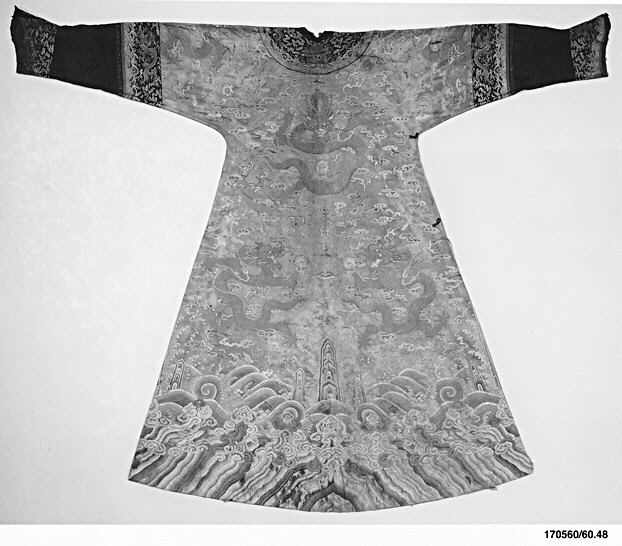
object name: robe, court, auspicious robe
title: "Auspicious" Court Robe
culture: chinese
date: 1723-1735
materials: metal thread, silk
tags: dragons